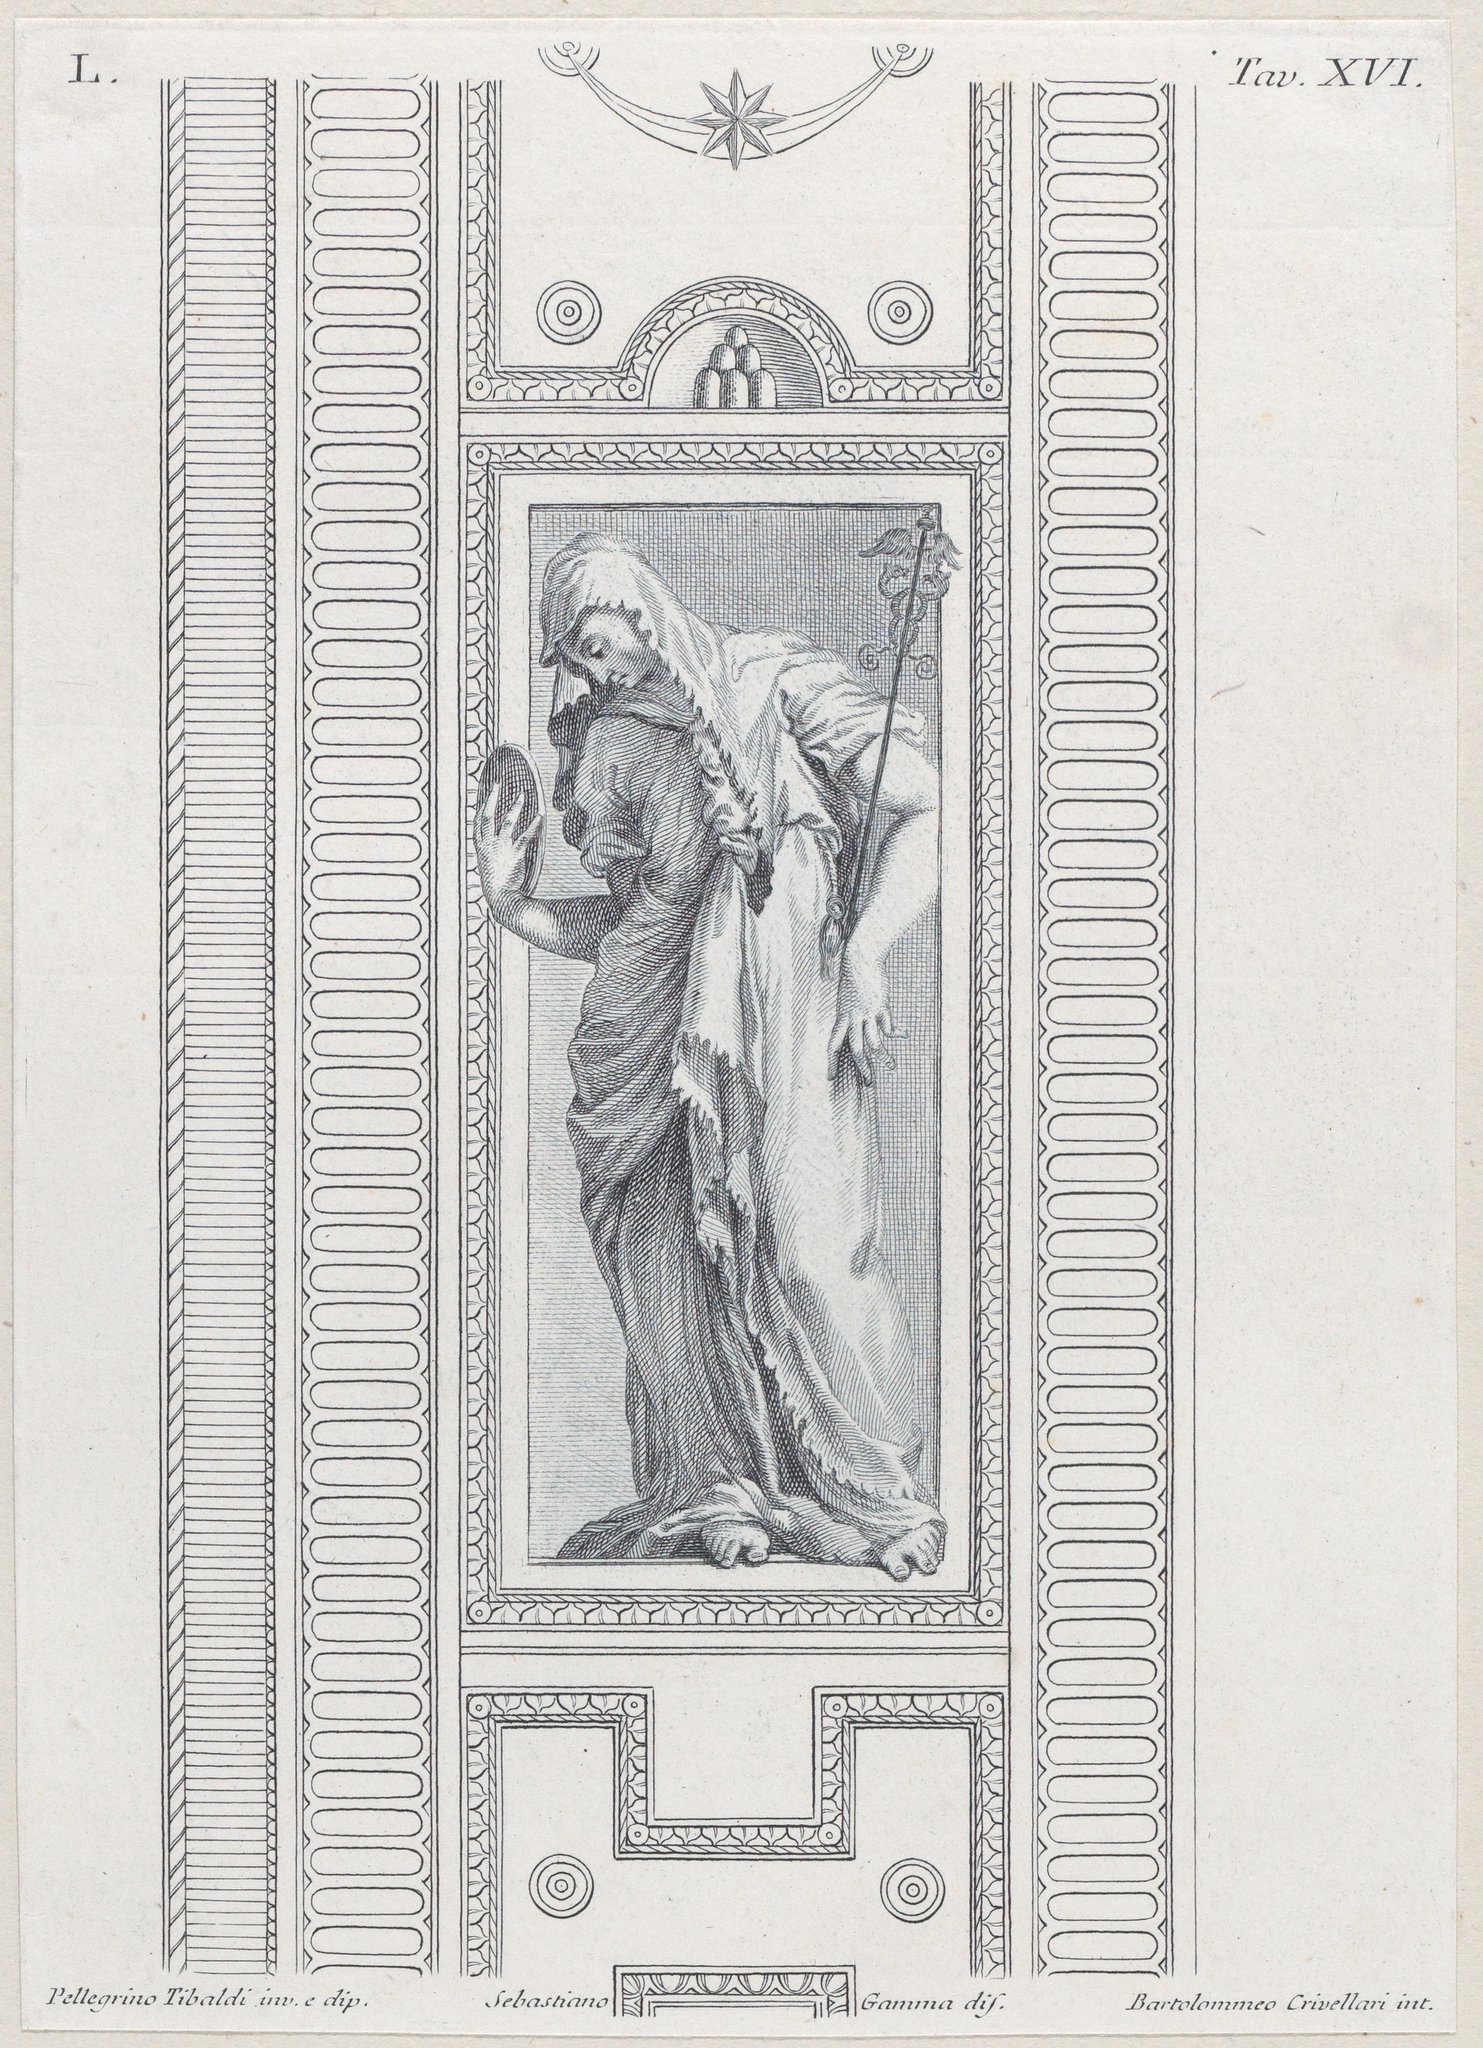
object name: print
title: Plate 16: mythological figure holding a mirror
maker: bartolomeo crivellari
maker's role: artist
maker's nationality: italian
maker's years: 1700-1800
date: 1756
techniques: engraving, etching